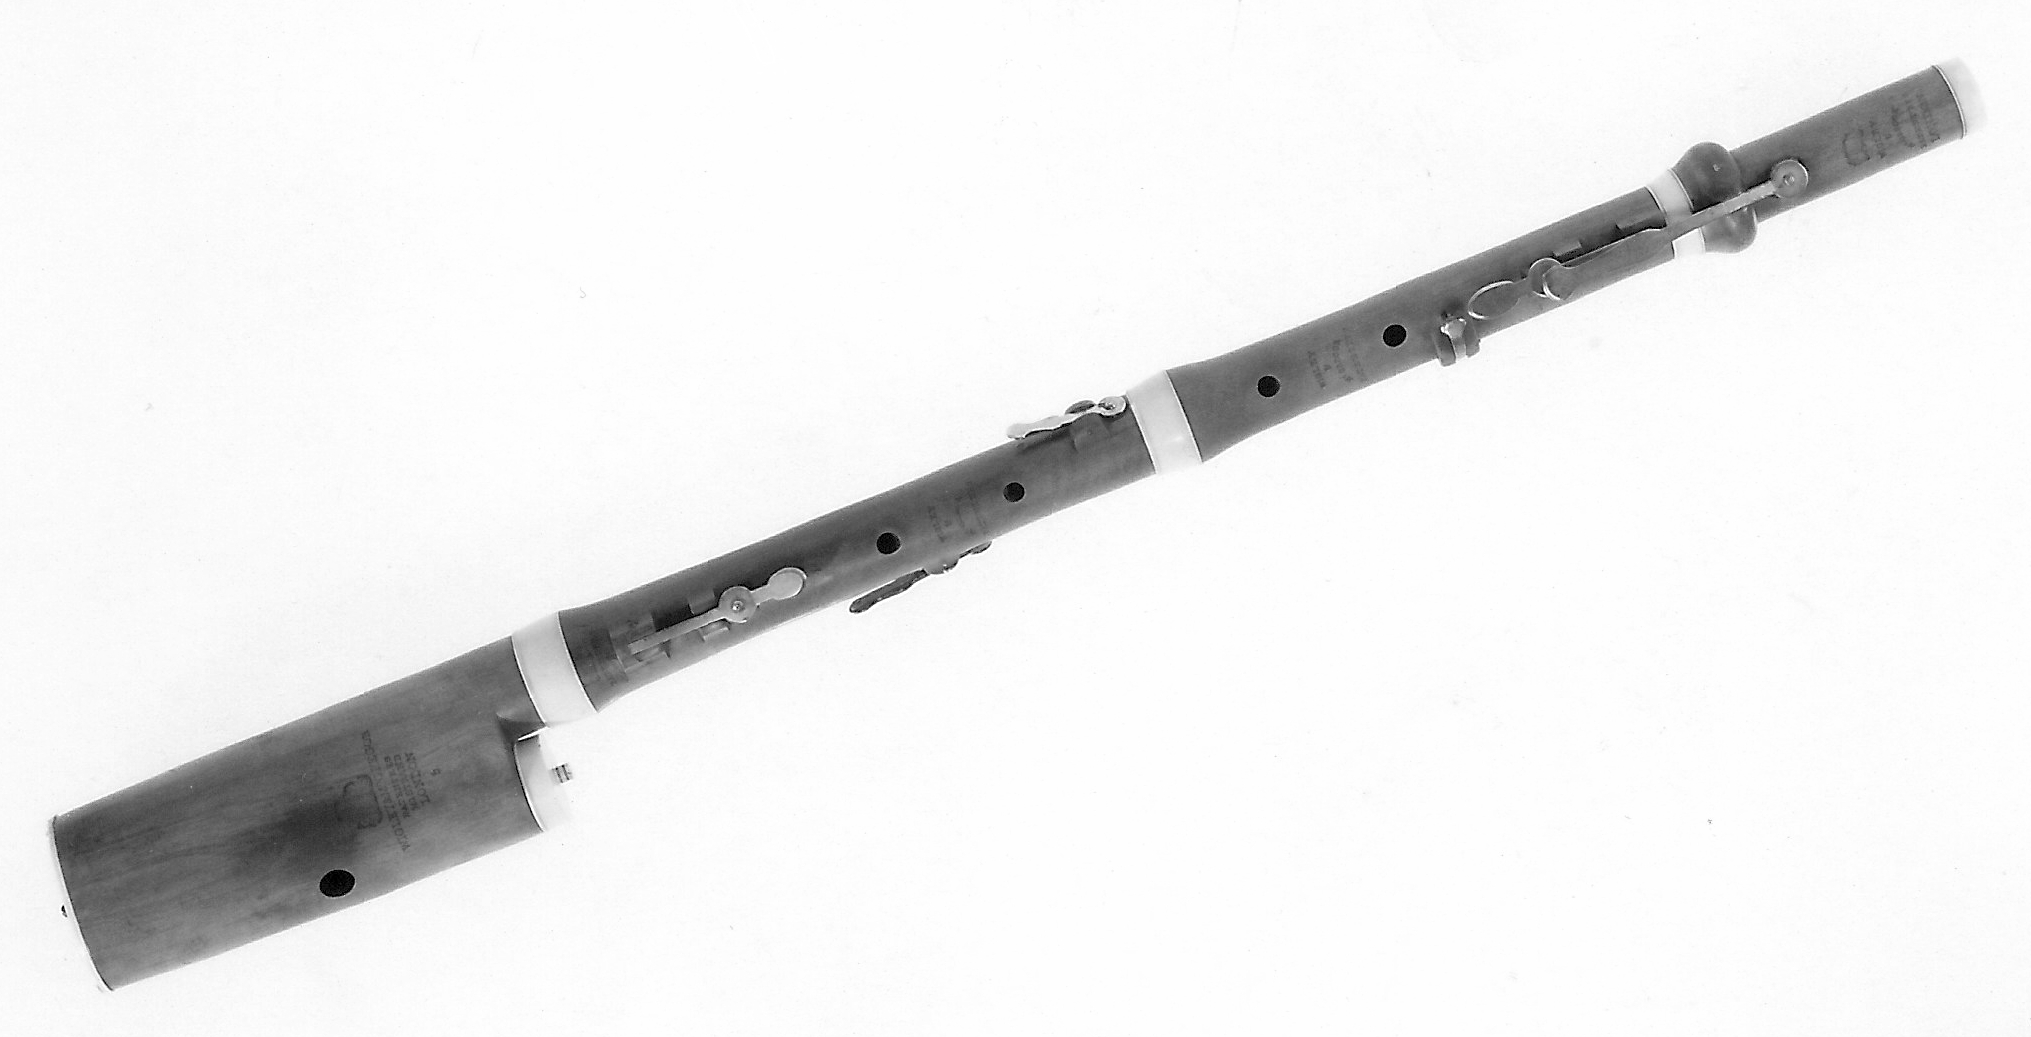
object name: transverse flute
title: Transverse Flute in A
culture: british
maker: wigley & mcgregor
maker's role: maker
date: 1811-1816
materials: ivory, silver, wood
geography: united kingdom